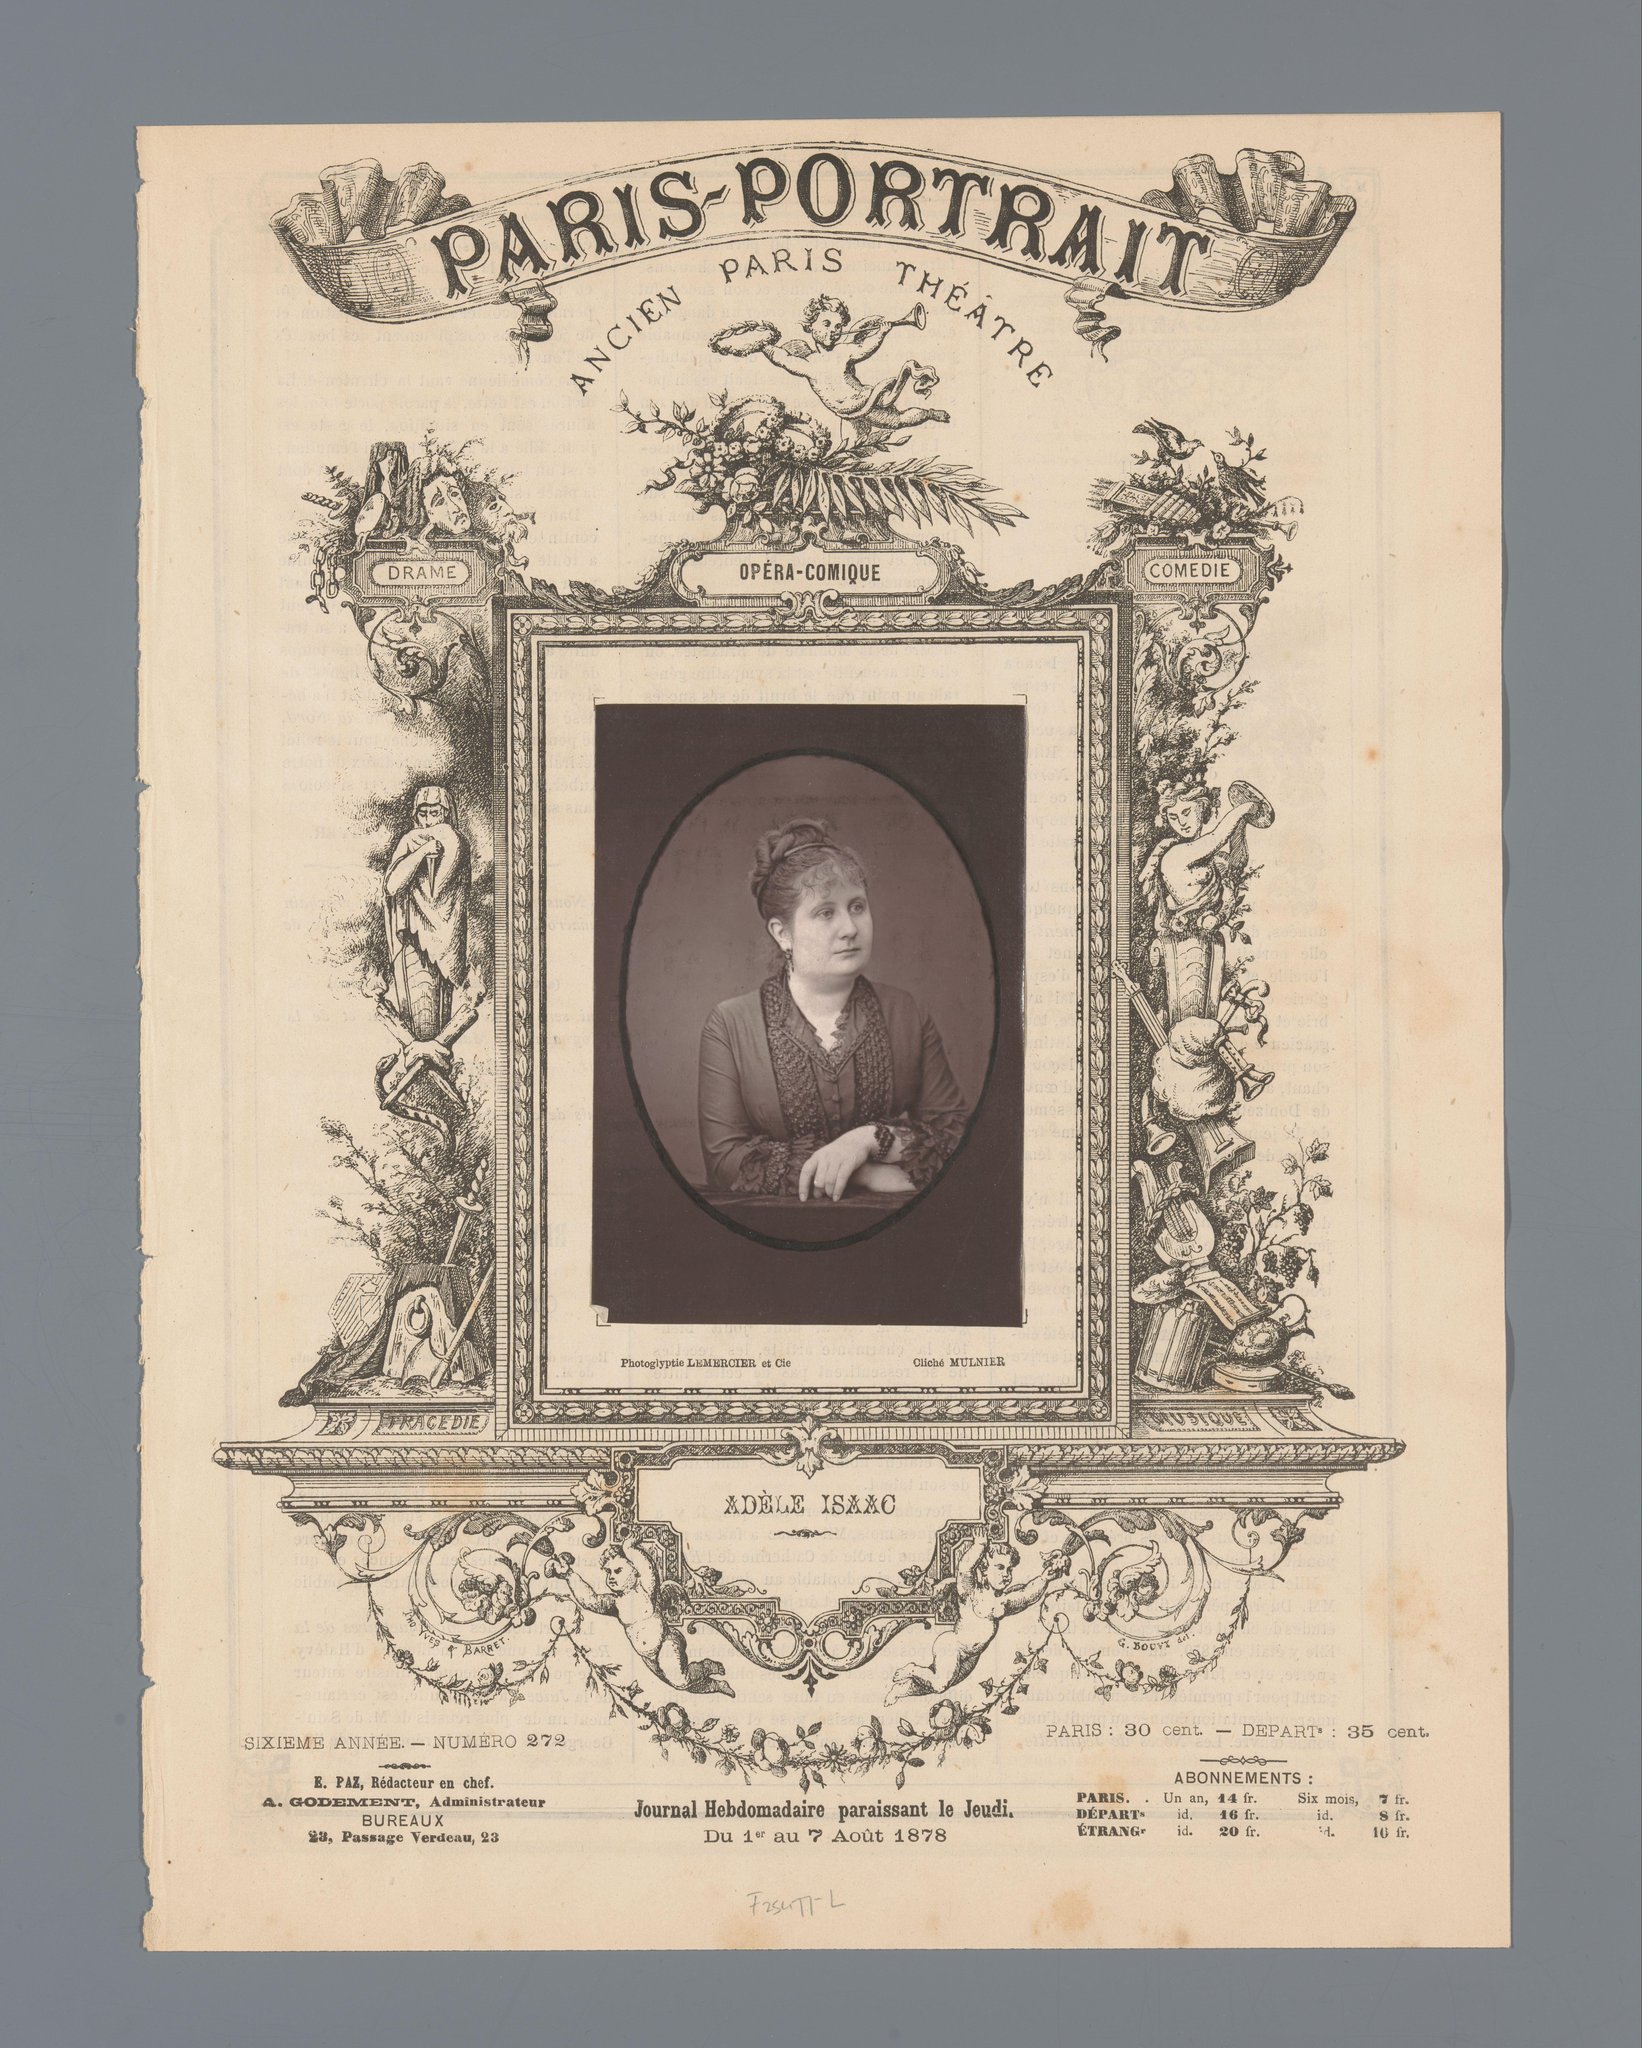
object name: photomechanical print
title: Adèle Isaac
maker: ferdinand mulnier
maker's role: painter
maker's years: 1817-1891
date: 1873-1880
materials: paper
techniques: woodburytype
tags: historical persons - bb - woman